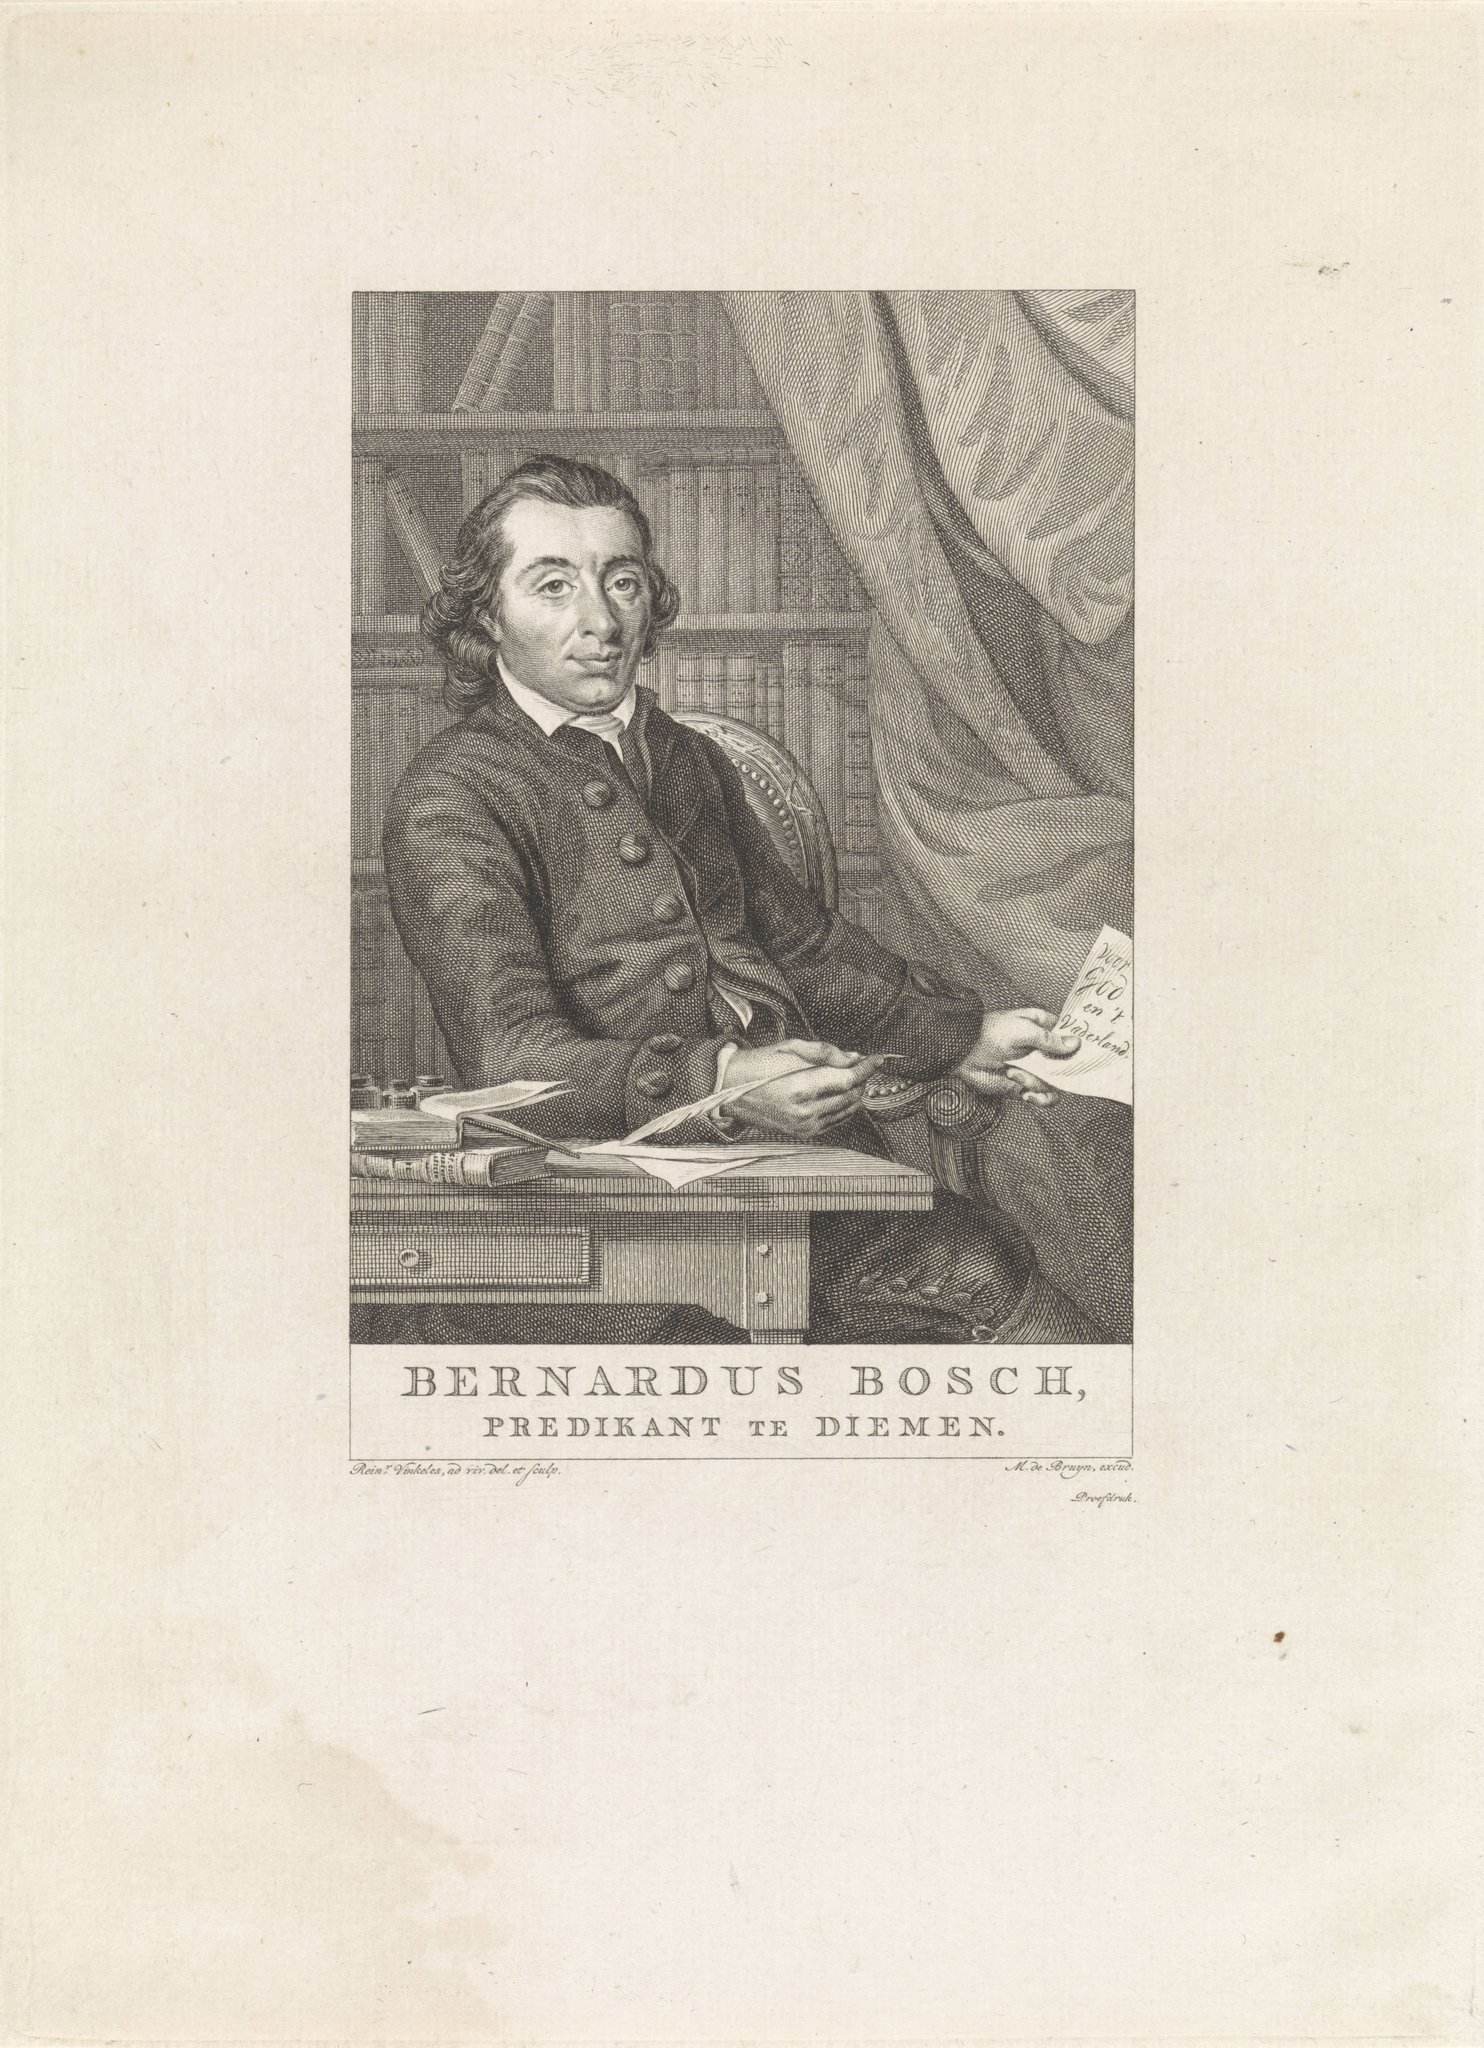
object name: print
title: Portret van Bernardus Bosch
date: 1782-1816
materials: paper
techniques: engraving, etching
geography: amsterdam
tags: deventer, quill, study; 'studiolo'; library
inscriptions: collector's mark: Lugt 2228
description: Portret van Bernardus de Bosch, predikant en dichter te Diemen.